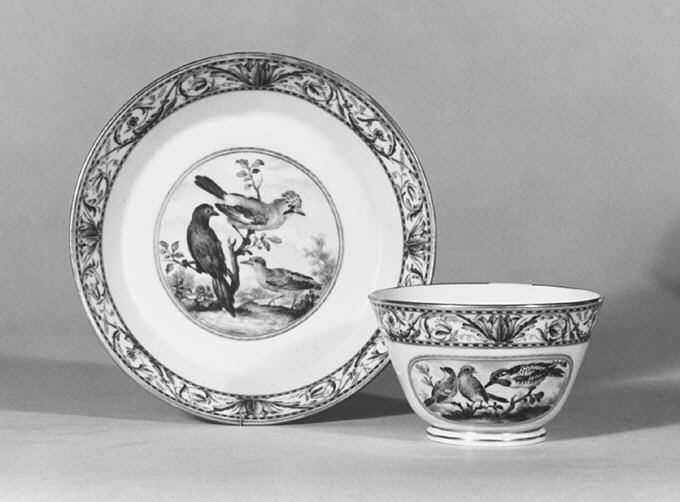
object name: teacup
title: Teacup (part of a service)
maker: meissen manufactory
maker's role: manufactory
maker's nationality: german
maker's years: 1710-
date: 1780-1785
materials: hard paste porcelain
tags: birds,trees